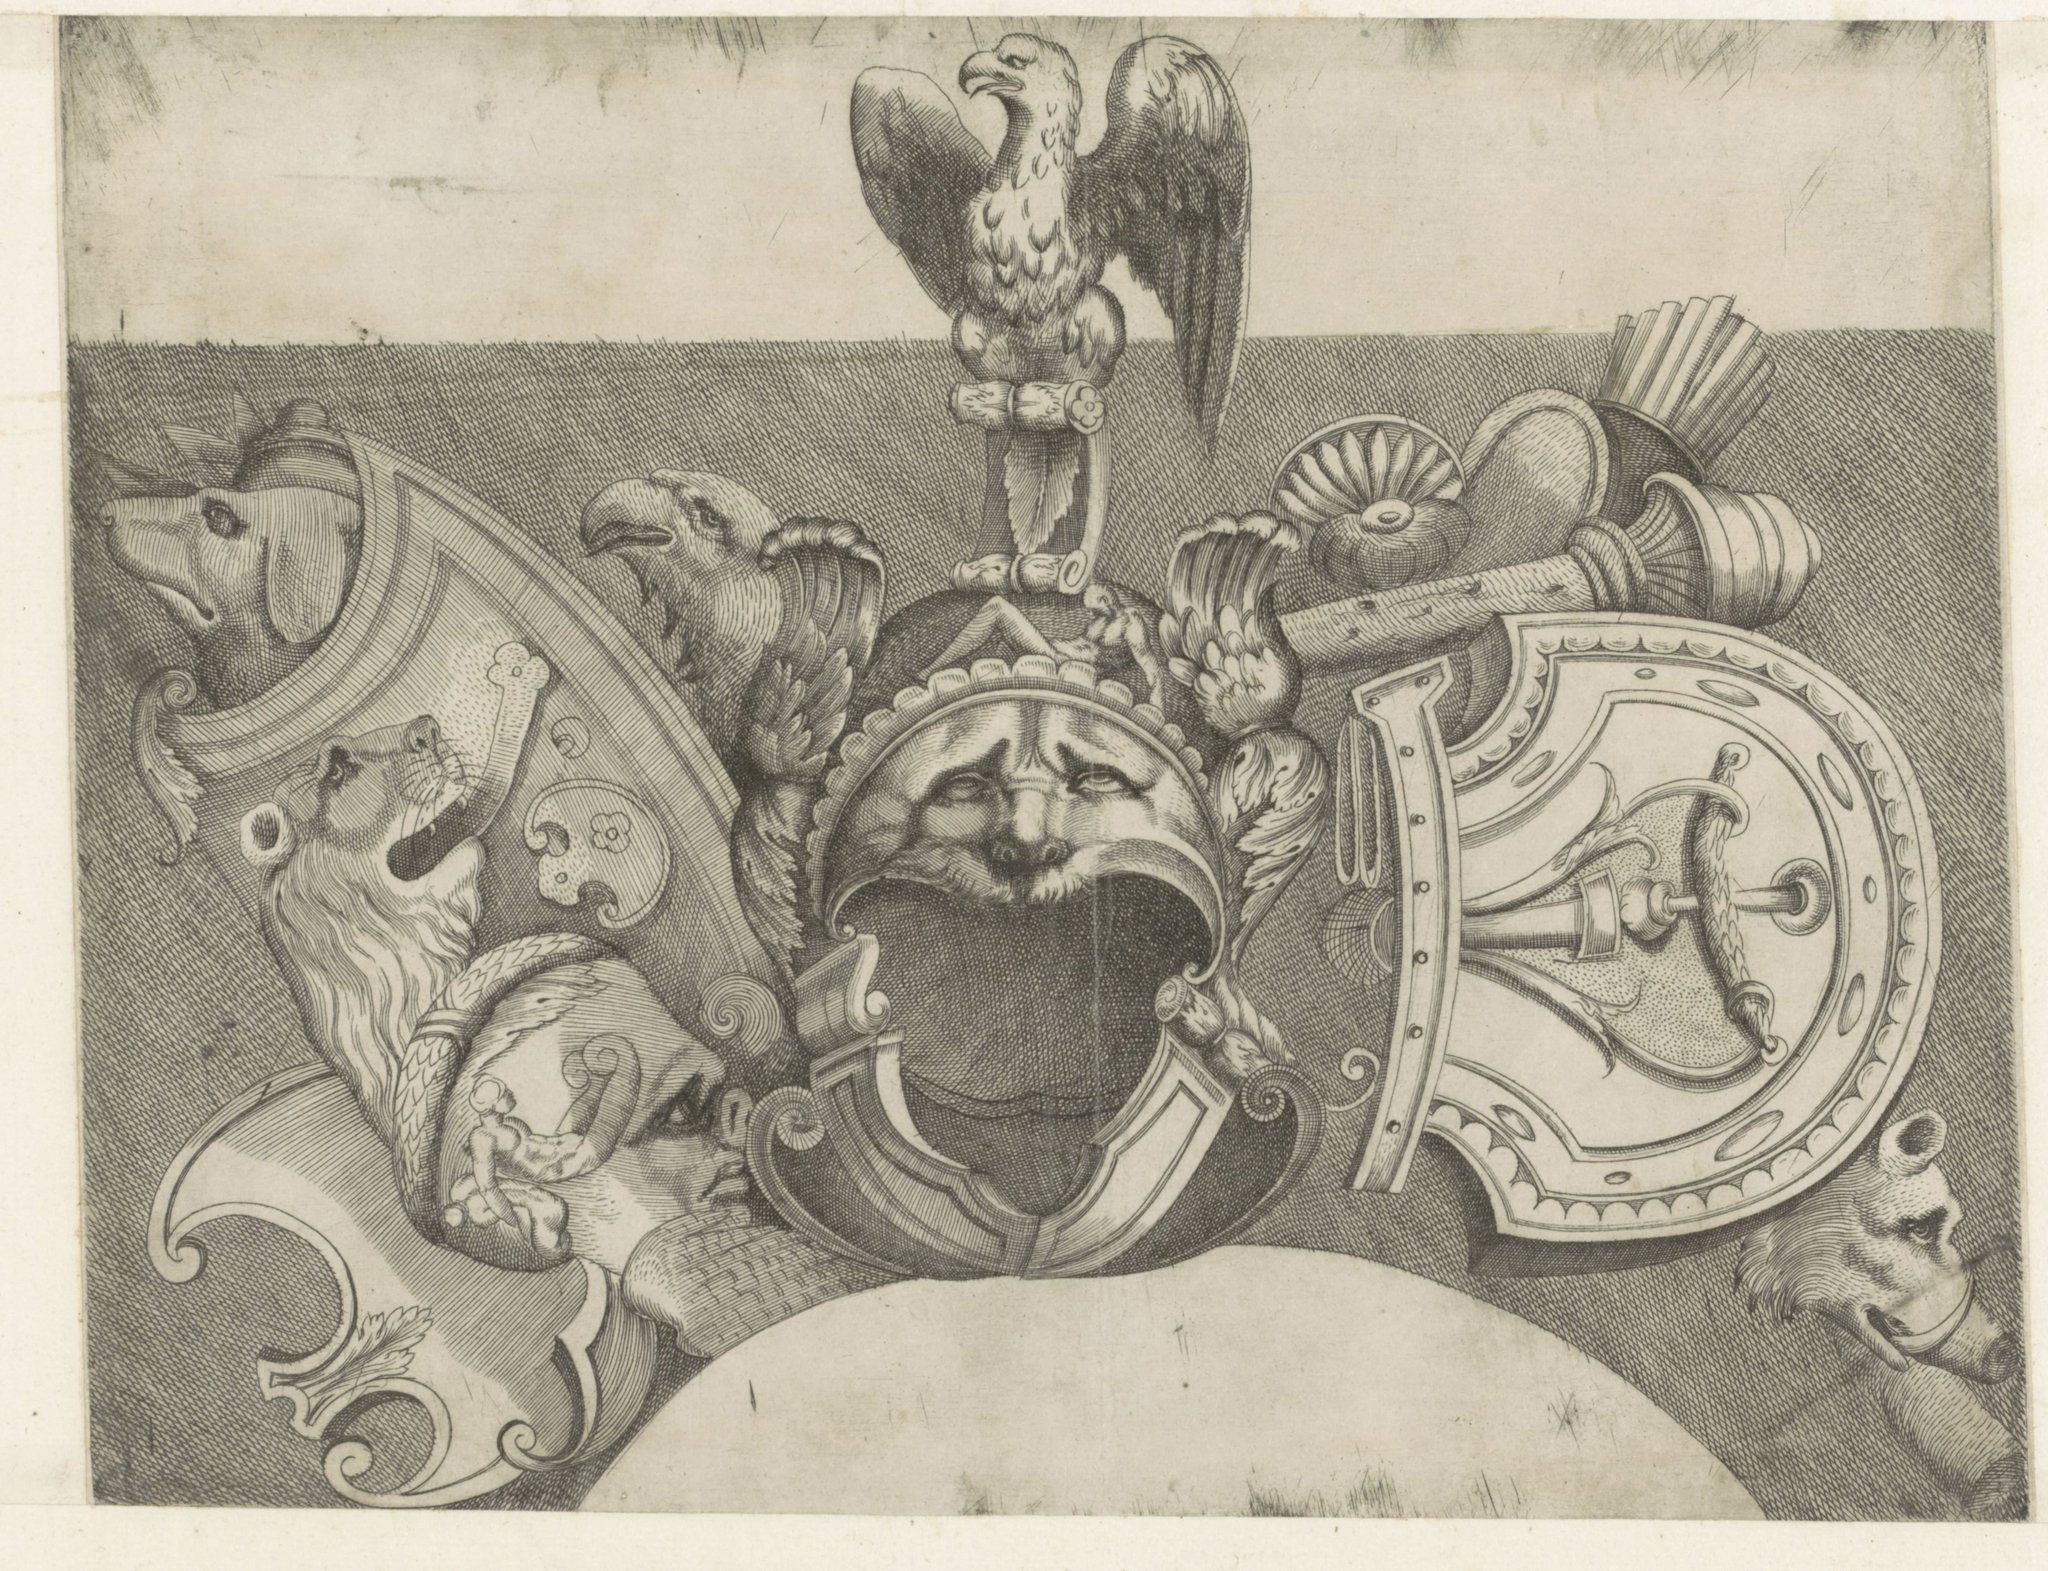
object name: album leaf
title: Trofee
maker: Anonymous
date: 1530-1570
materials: paper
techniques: engraving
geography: italy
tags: trophy, i.e.: decorative arrangement of symbolic or typical objects ~ ornament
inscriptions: number: ‘118’, collector's mark: Lugt 2760, collector's mark: Lugt 2228, watermark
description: Folio 118 uit het prentalbum van Johann Georg I. Zobel von Giebelstadt (Röttingen 1543-07-20 - Bamberg 1580-09-07), de latere bisschop van Bamberg. Het album is vermoedelijk samengesteld tussen 1568 en 1570 in Venetië. Het album werd in 1999 uit elkaar genomen door een antiquair. De in totaal 124 folio's met prenten uit het "Zobel Album" werden aangekocht door verschillende musea en privéverzamelingen. De grootste groep (68 folio's) bevindt zich in de collectie van het Rijksmuseum. Naar een prent (uit een serie van zes prenten) van Polidoro da Caravaggio (New York, Metropolitan Museum of Art, inv. nr.: 2012.193(6)).